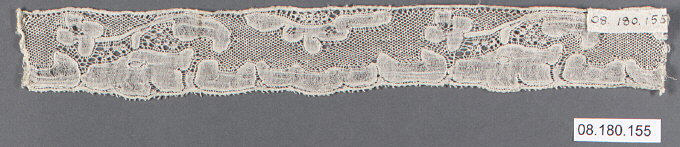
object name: piece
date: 1701-1800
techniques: lace